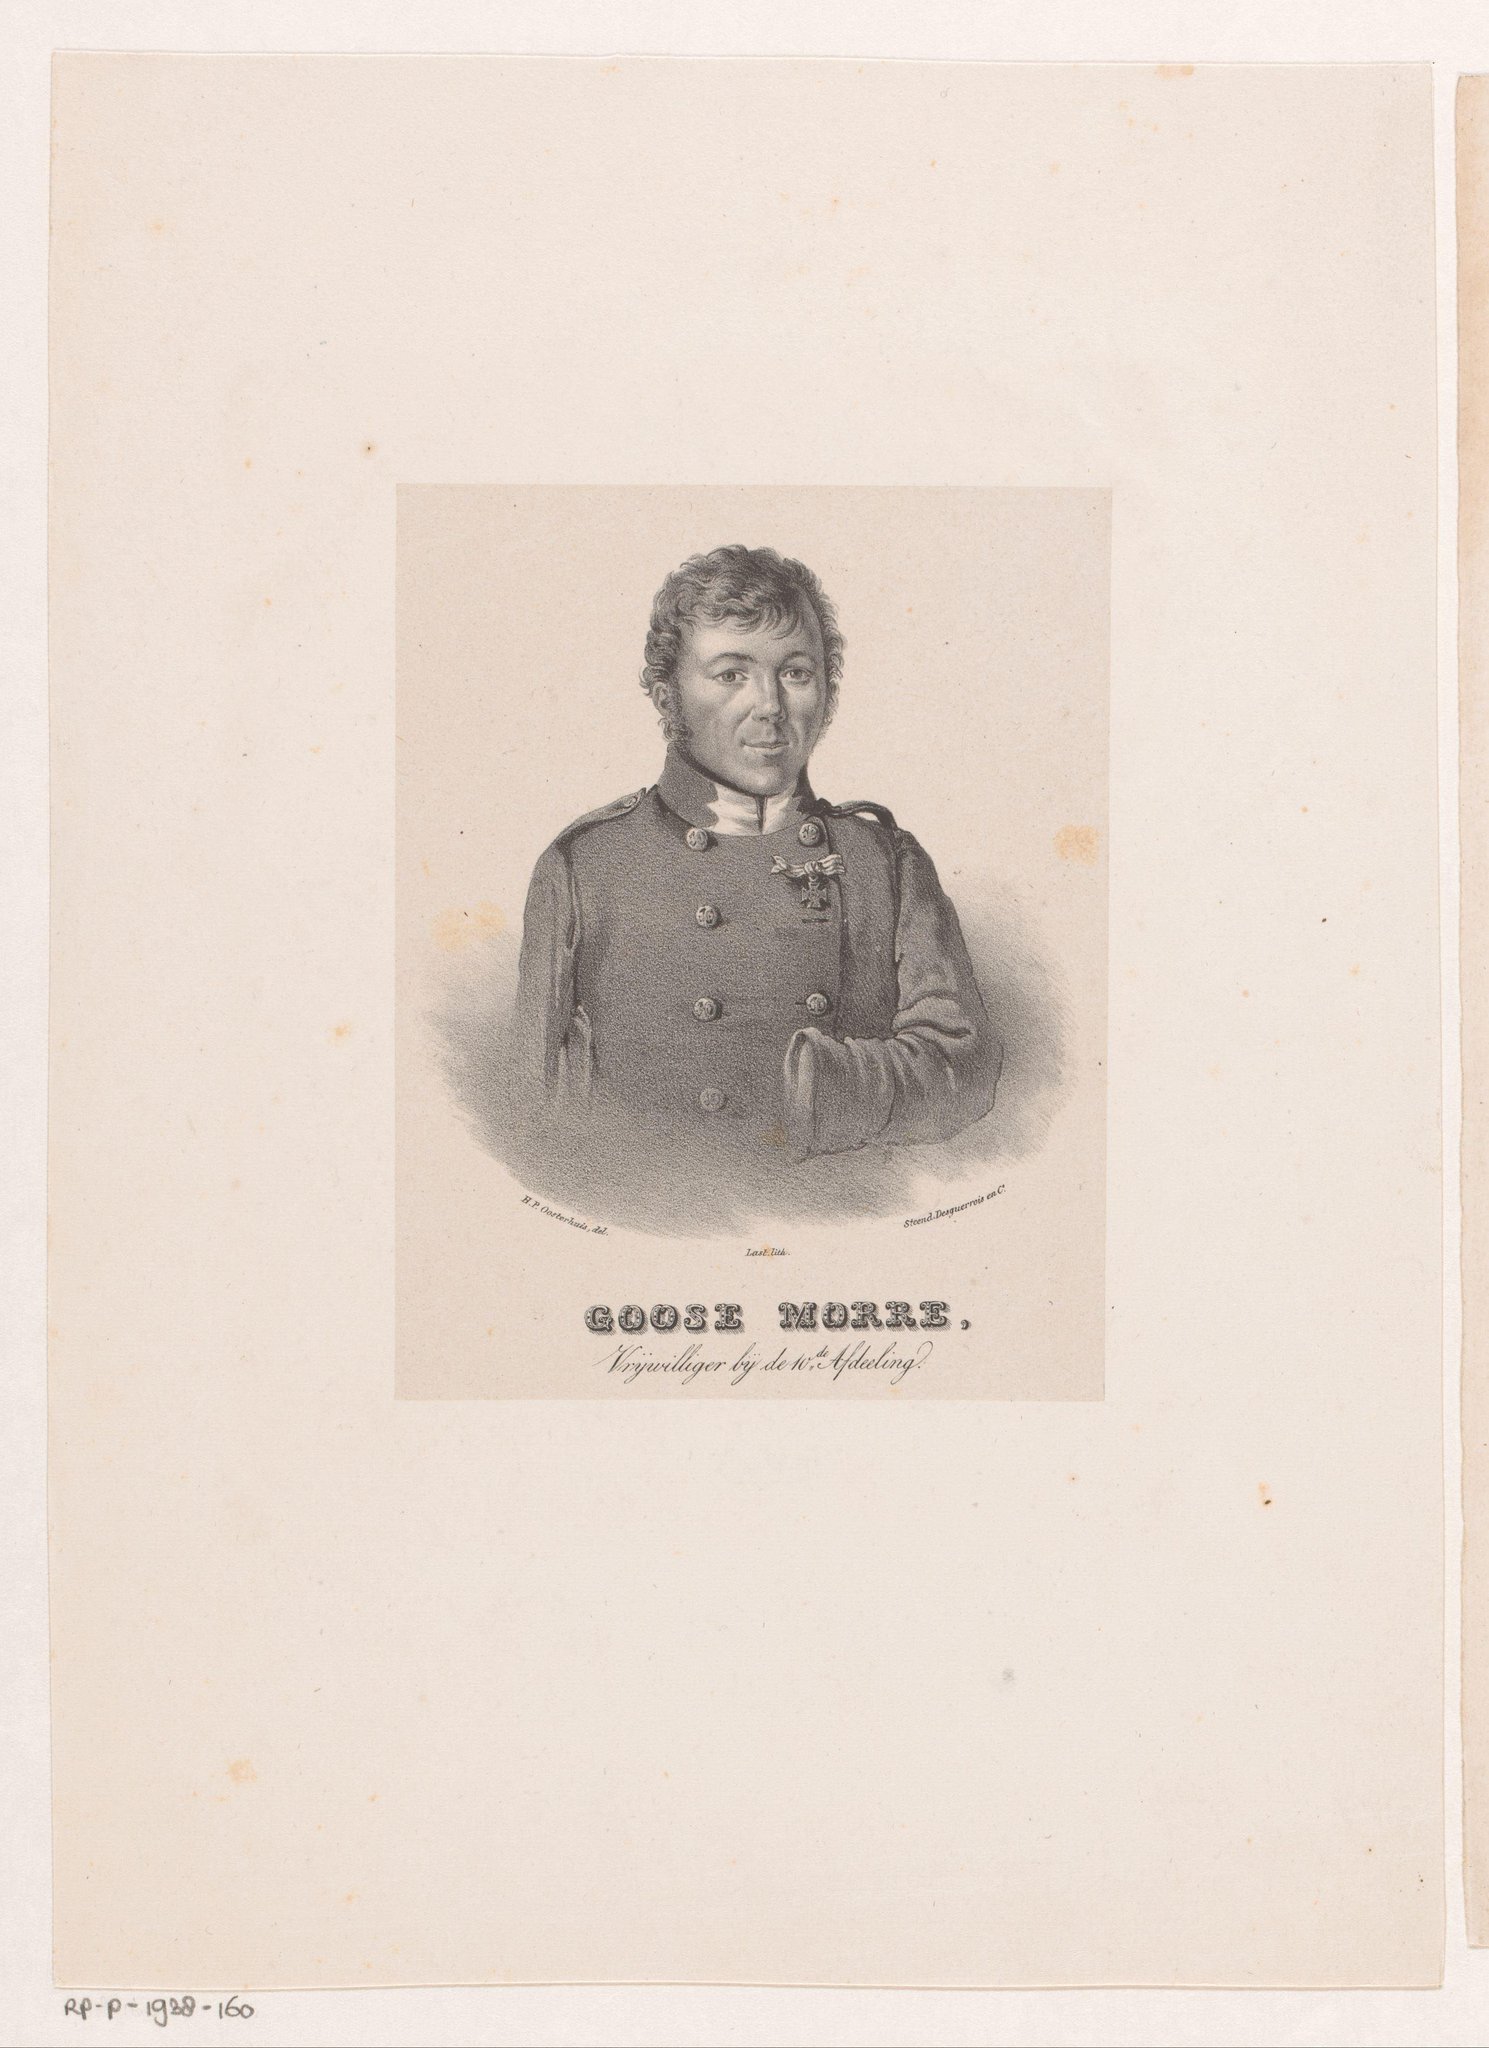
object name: print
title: Portret van Goose Morre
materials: paper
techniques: lithograph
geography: amsterdam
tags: disabilities, deformations, historical persons (+ (full) bust portrait)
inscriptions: collector's mark: Lugt 2228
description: De geportretteerde is afgebeeld in militair uniform met een ridderorde op zijn borst. Tijdens het beleg van het citadel van Antwerpen verloor hij zijn rechterarm en linkerhand. Onder het portret zijn naam en beroep.